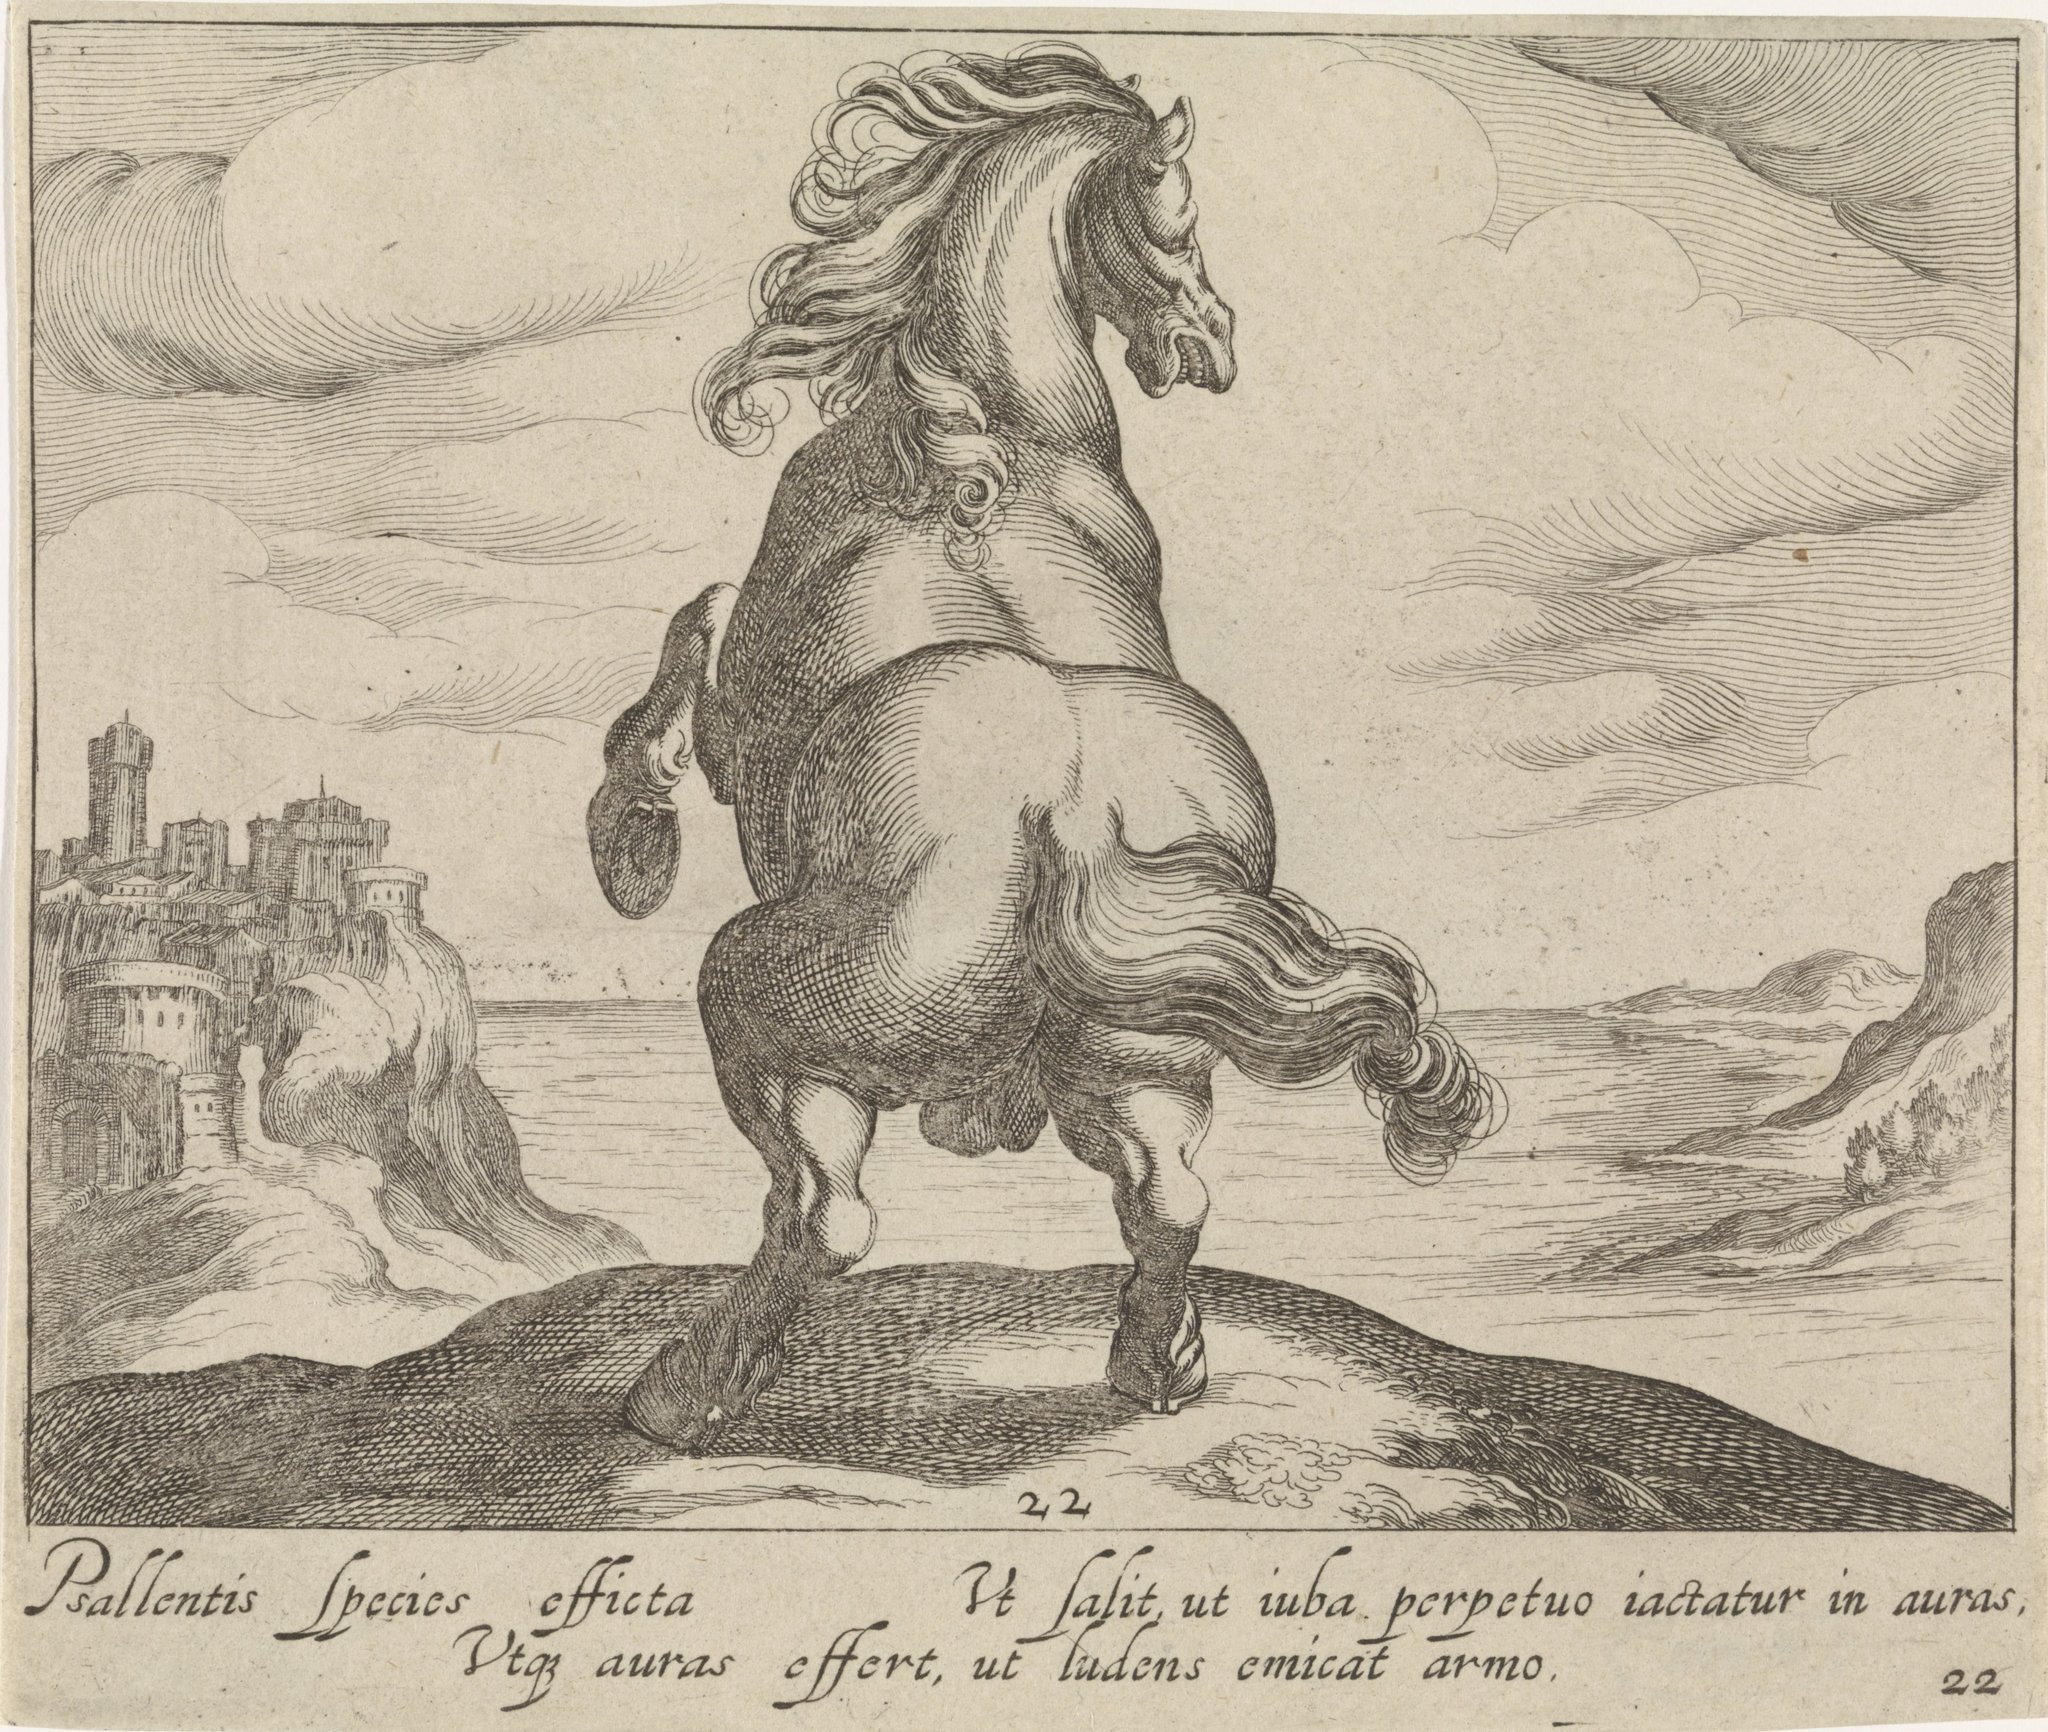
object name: print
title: Landschap met steigerende hengst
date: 1590-1637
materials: paper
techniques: engraving, etching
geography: amsterdam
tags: horse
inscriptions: collector's mark: Lugt 2228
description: Heuvelachtig landschap met steigerend paard, op de rug gezien, aan de kust. In de marge een tweeregelig onderschrift in het Latijn. Prent uit een serie van dertig met paardenrassen.